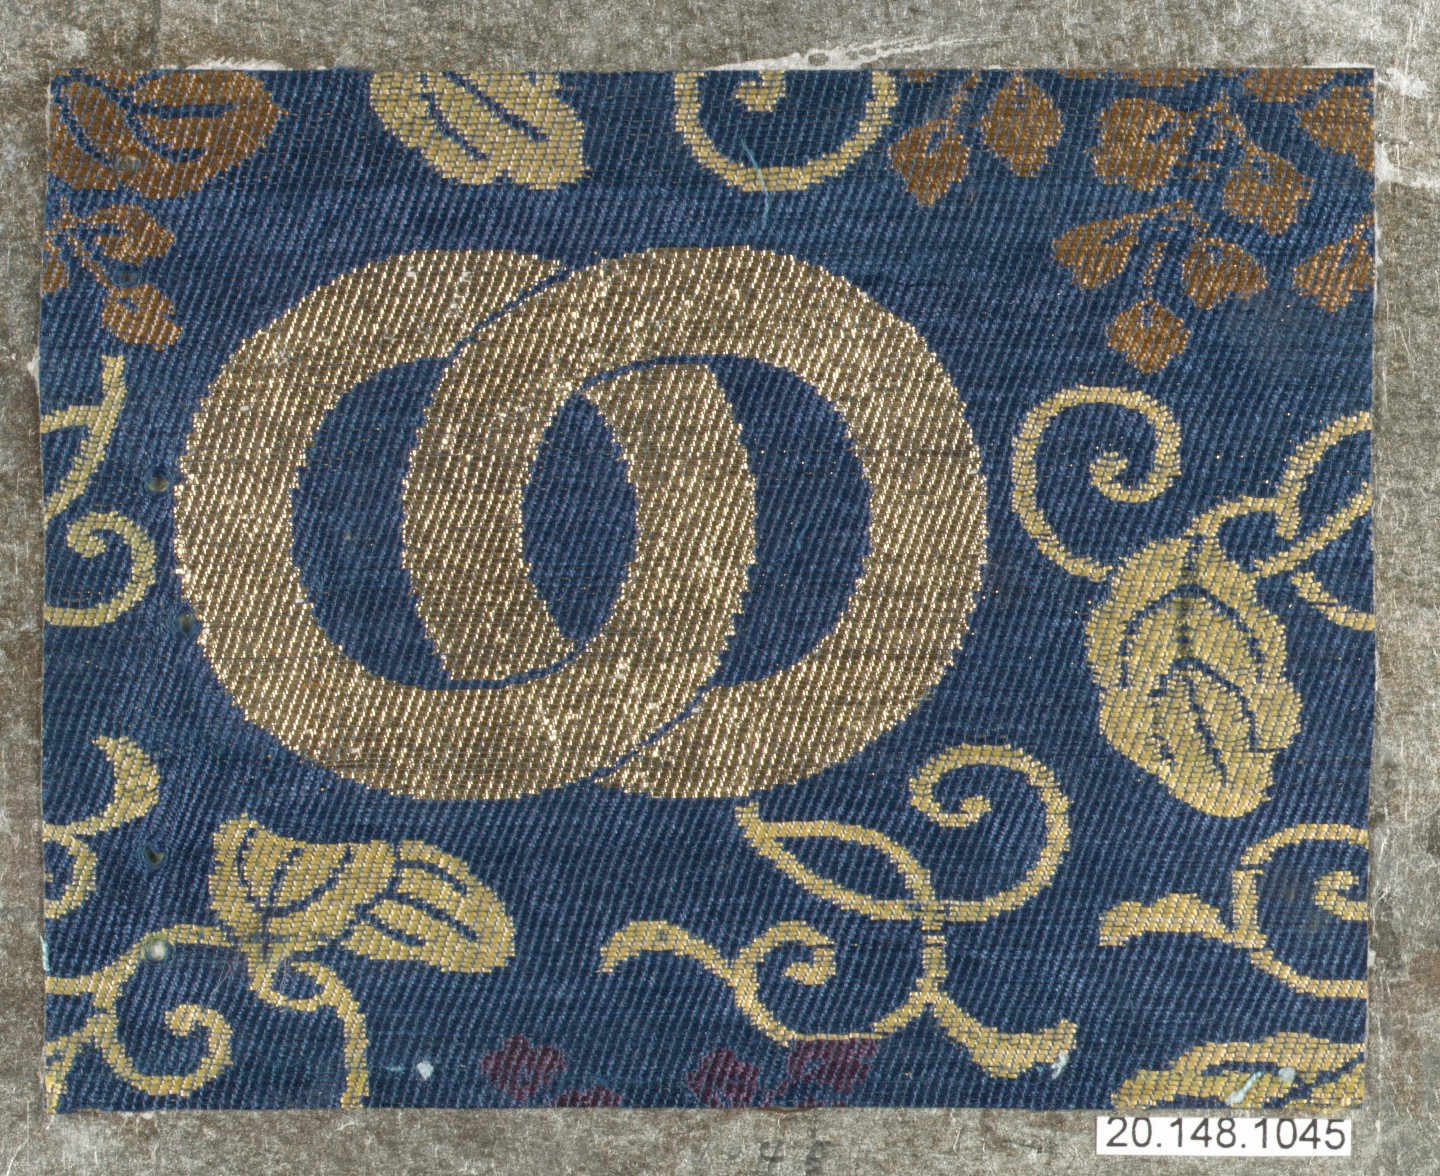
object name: piece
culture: japanese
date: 1801-1900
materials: silk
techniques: compound weave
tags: leaves